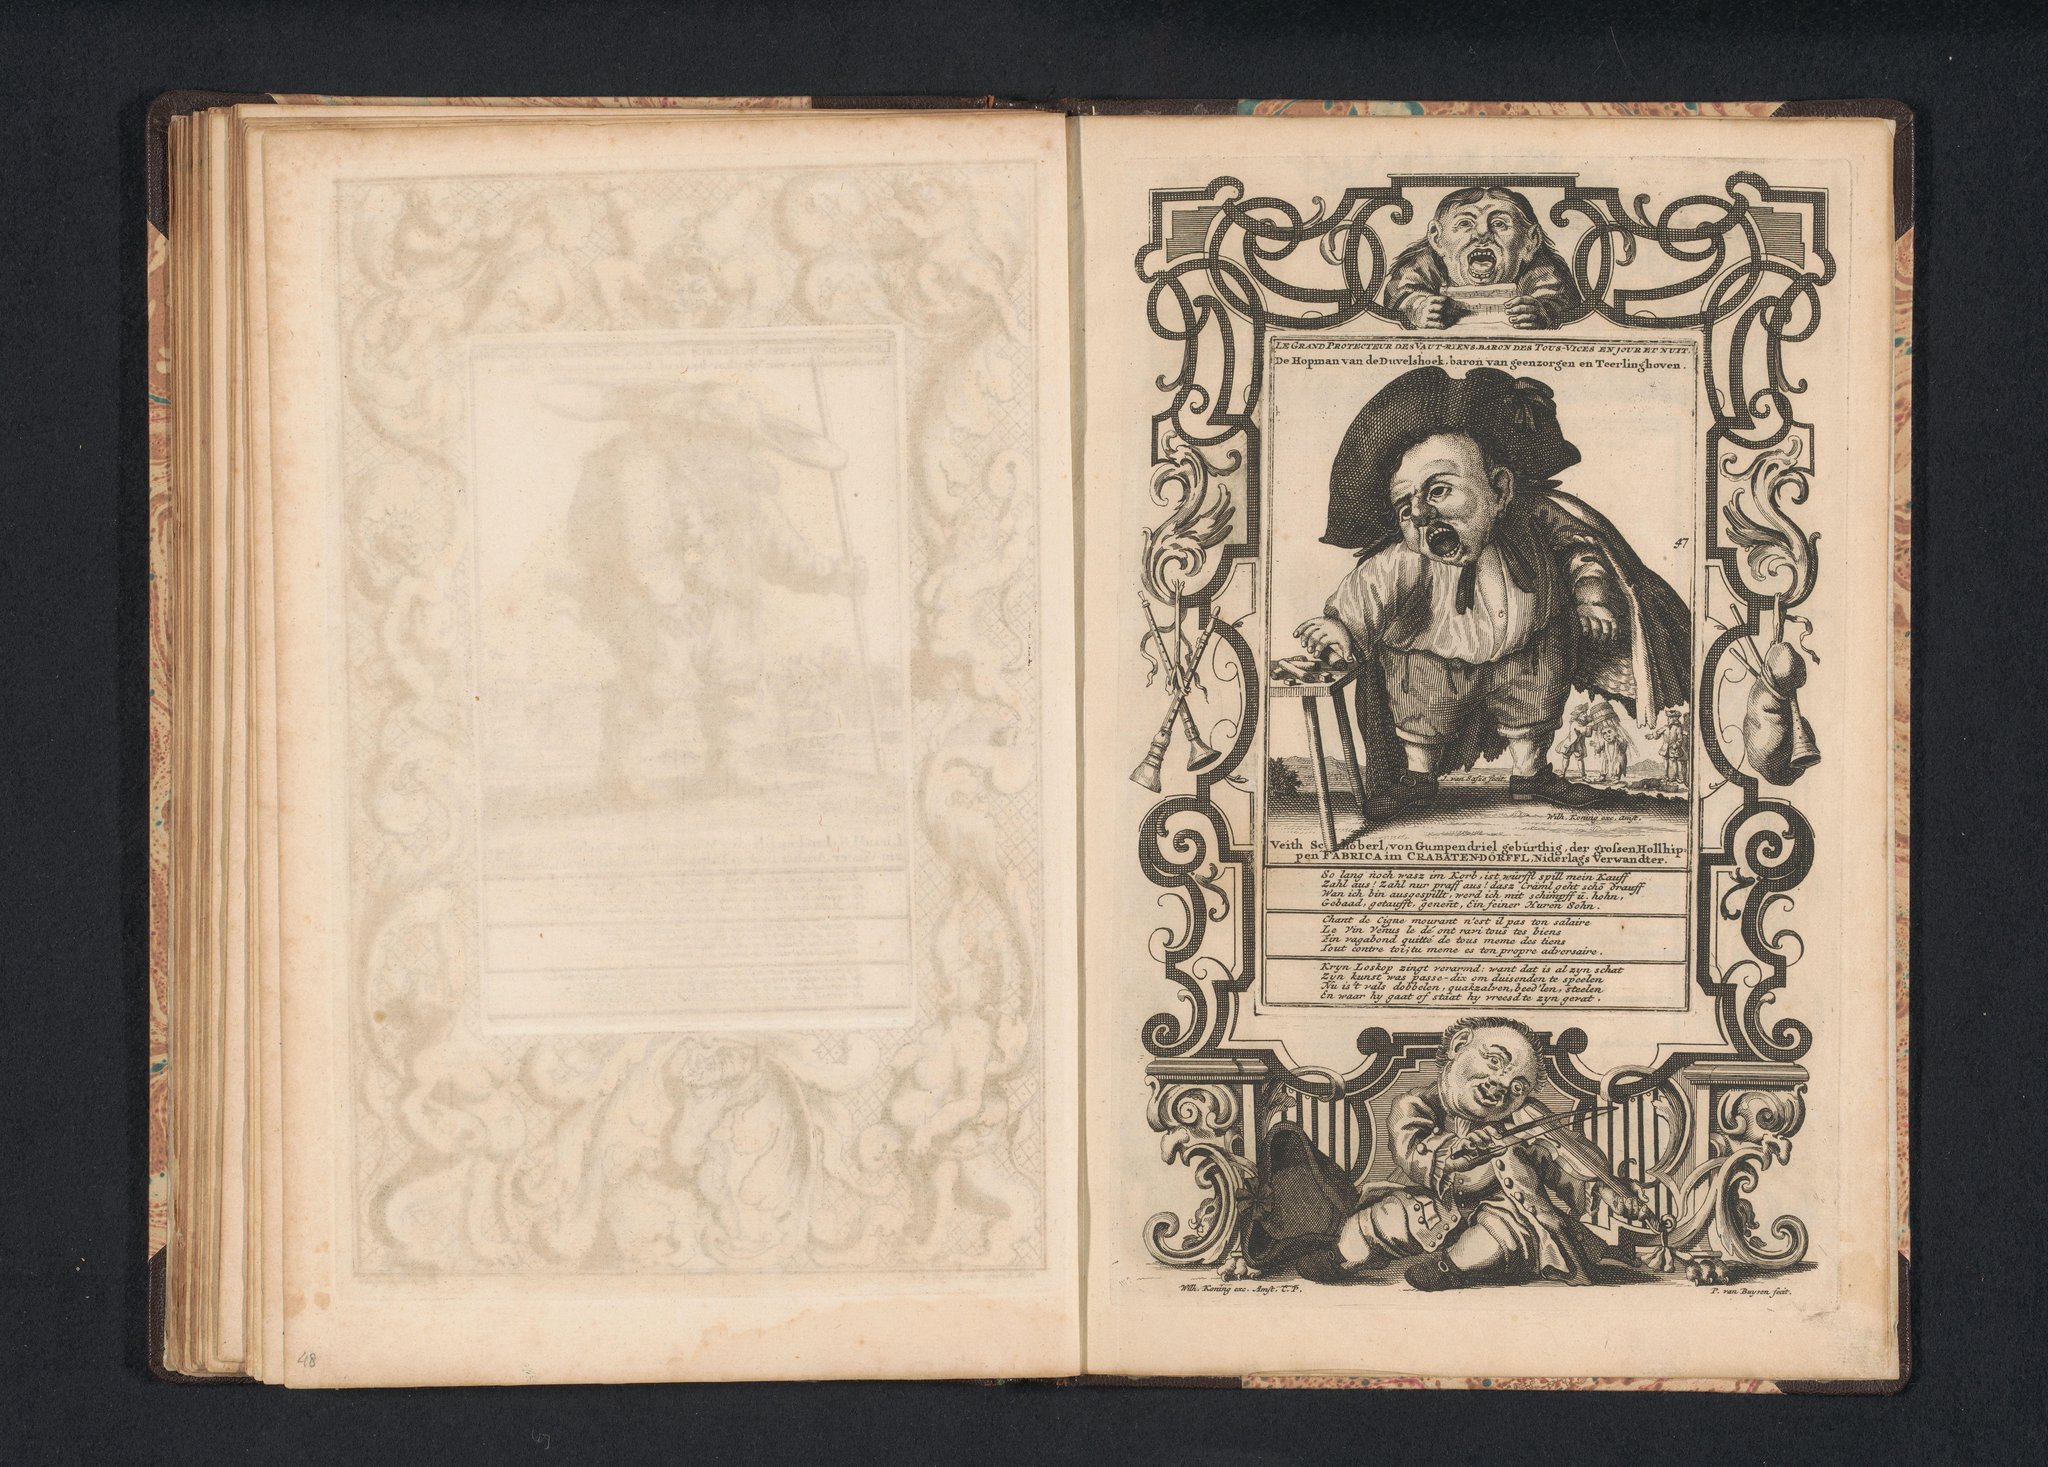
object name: print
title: De dwerg Hopman van Duvelshoek, 1716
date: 1716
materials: paper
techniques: etching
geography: northern netherlands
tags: male singer, caricatures (human types), little people, violin, fiddle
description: De kleine mens Hopman van Duvelshoek. In het onderschrift verzen in het Duits, Frans en Nederlands. Afdruk binnen een decoratieve omlijsting gedrukt van een aparte plaat met een zingende en een vioolspelende kleine mens. Genummerd rechts midden: 47. Onderdeel van de Nederlandse gebonden uitgave uit 1716 van een serie karikaturen van kleine mensen, bekend als Het Dwergentooneel, gekopieerd naar een ouder Duits voorbeeld.